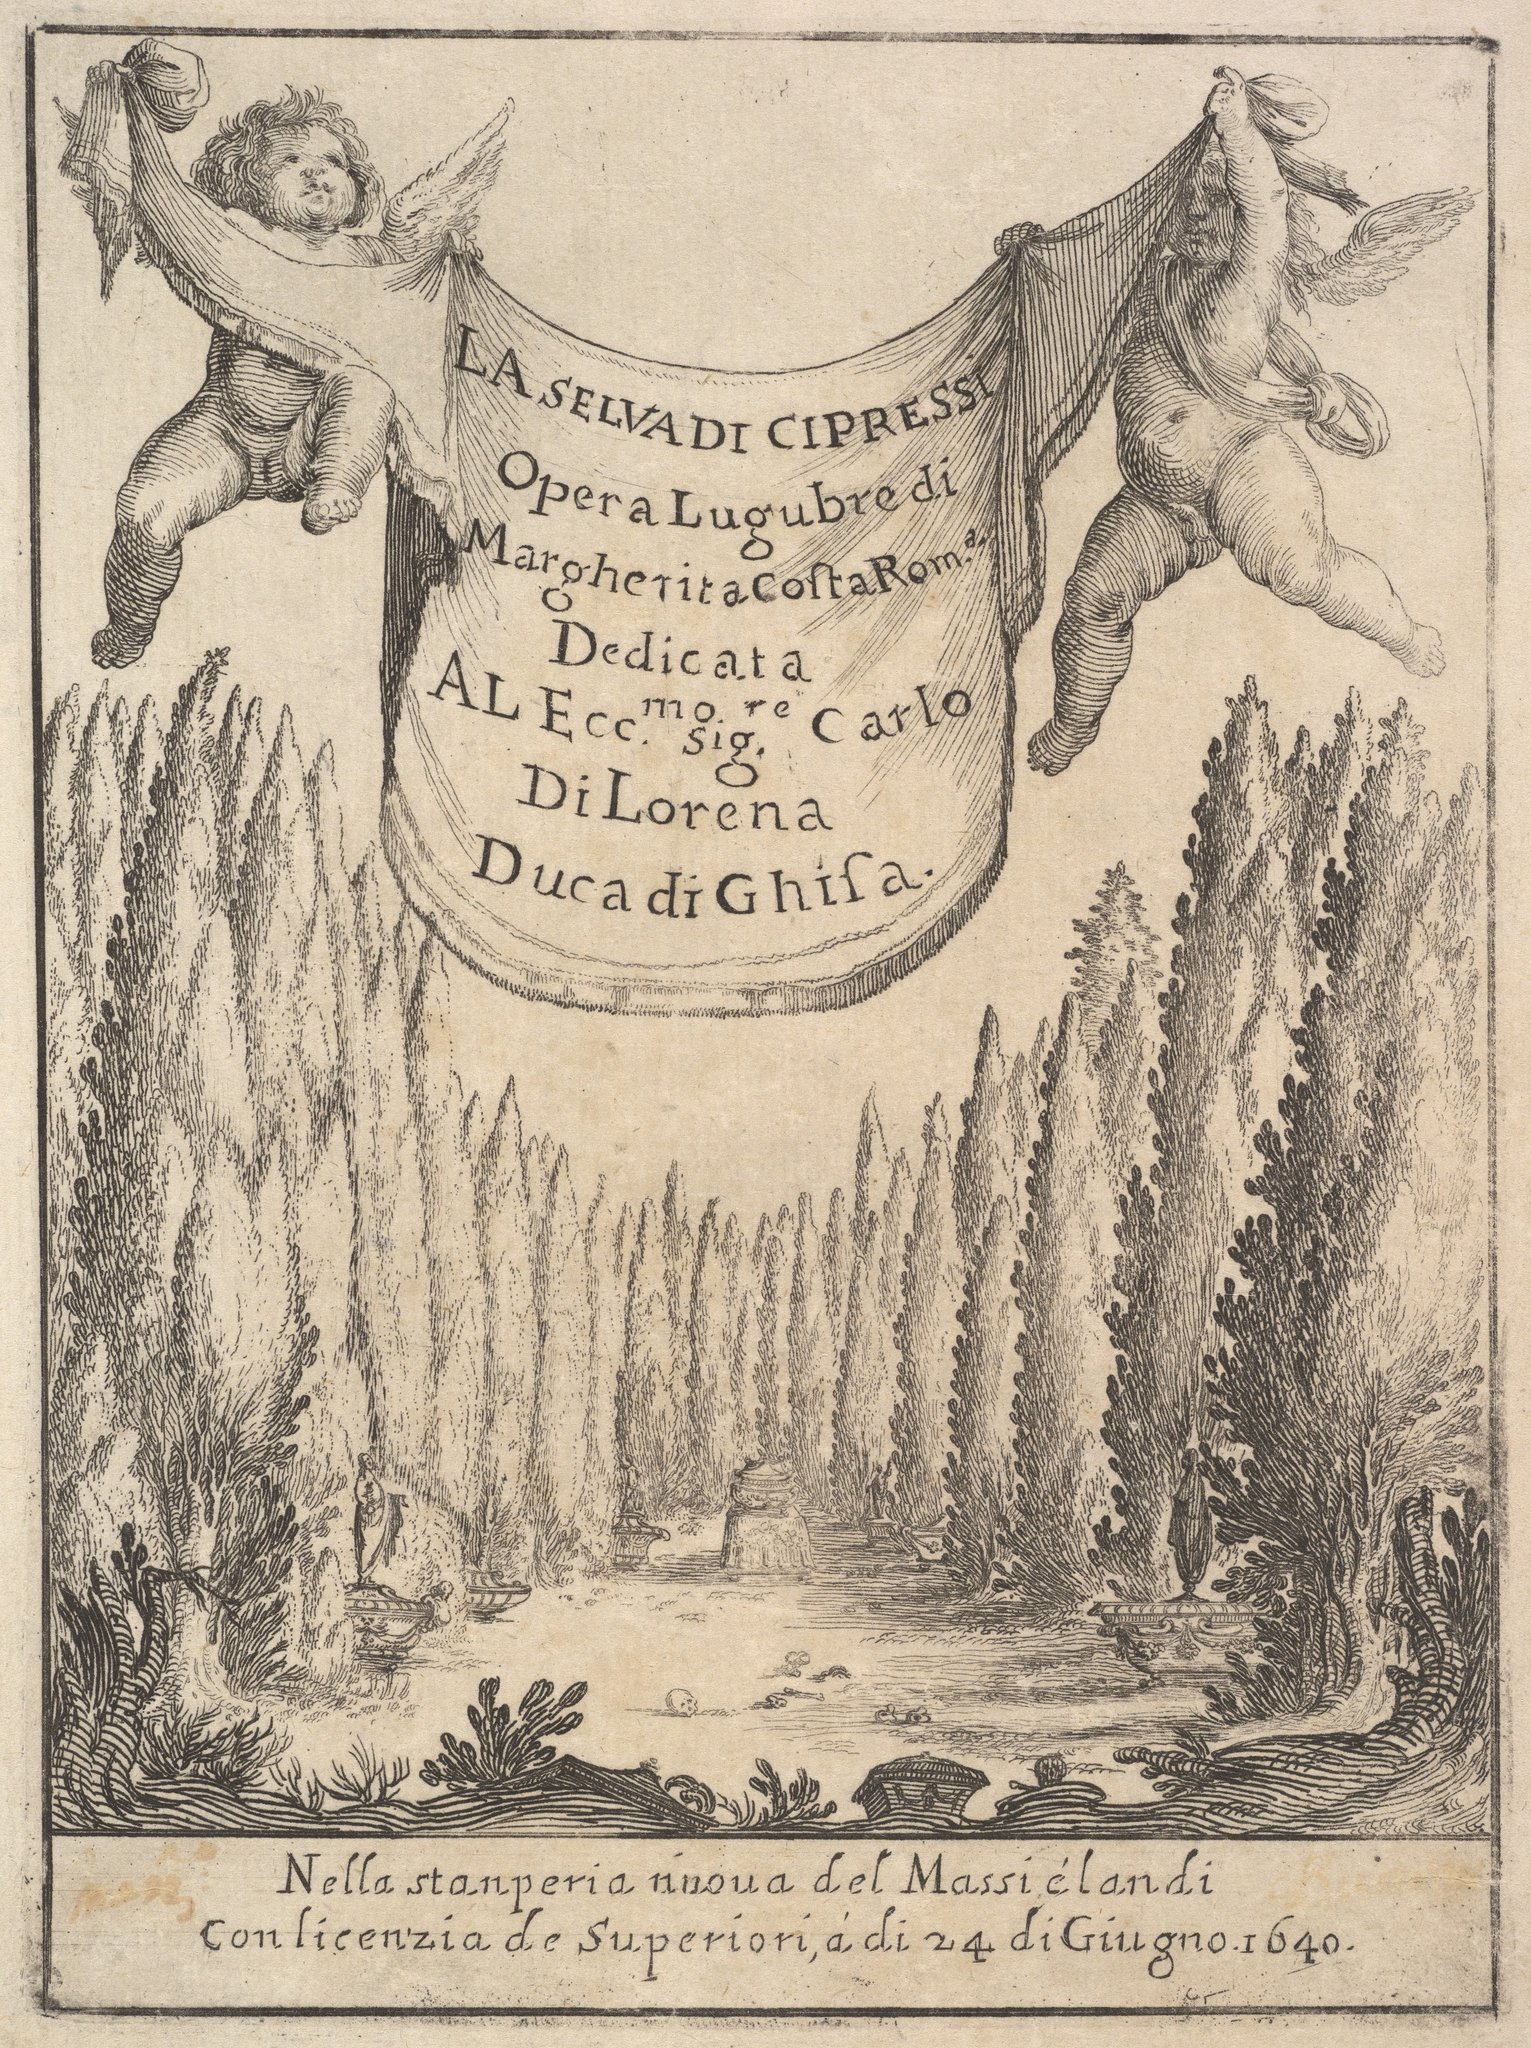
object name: print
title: Frontispiece for "The Cypress Forest" (La selva di cipressi)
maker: stefano della bella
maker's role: artist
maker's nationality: italian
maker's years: 1610-1664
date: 1640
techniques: etching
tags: sculpture,forests,cypresses